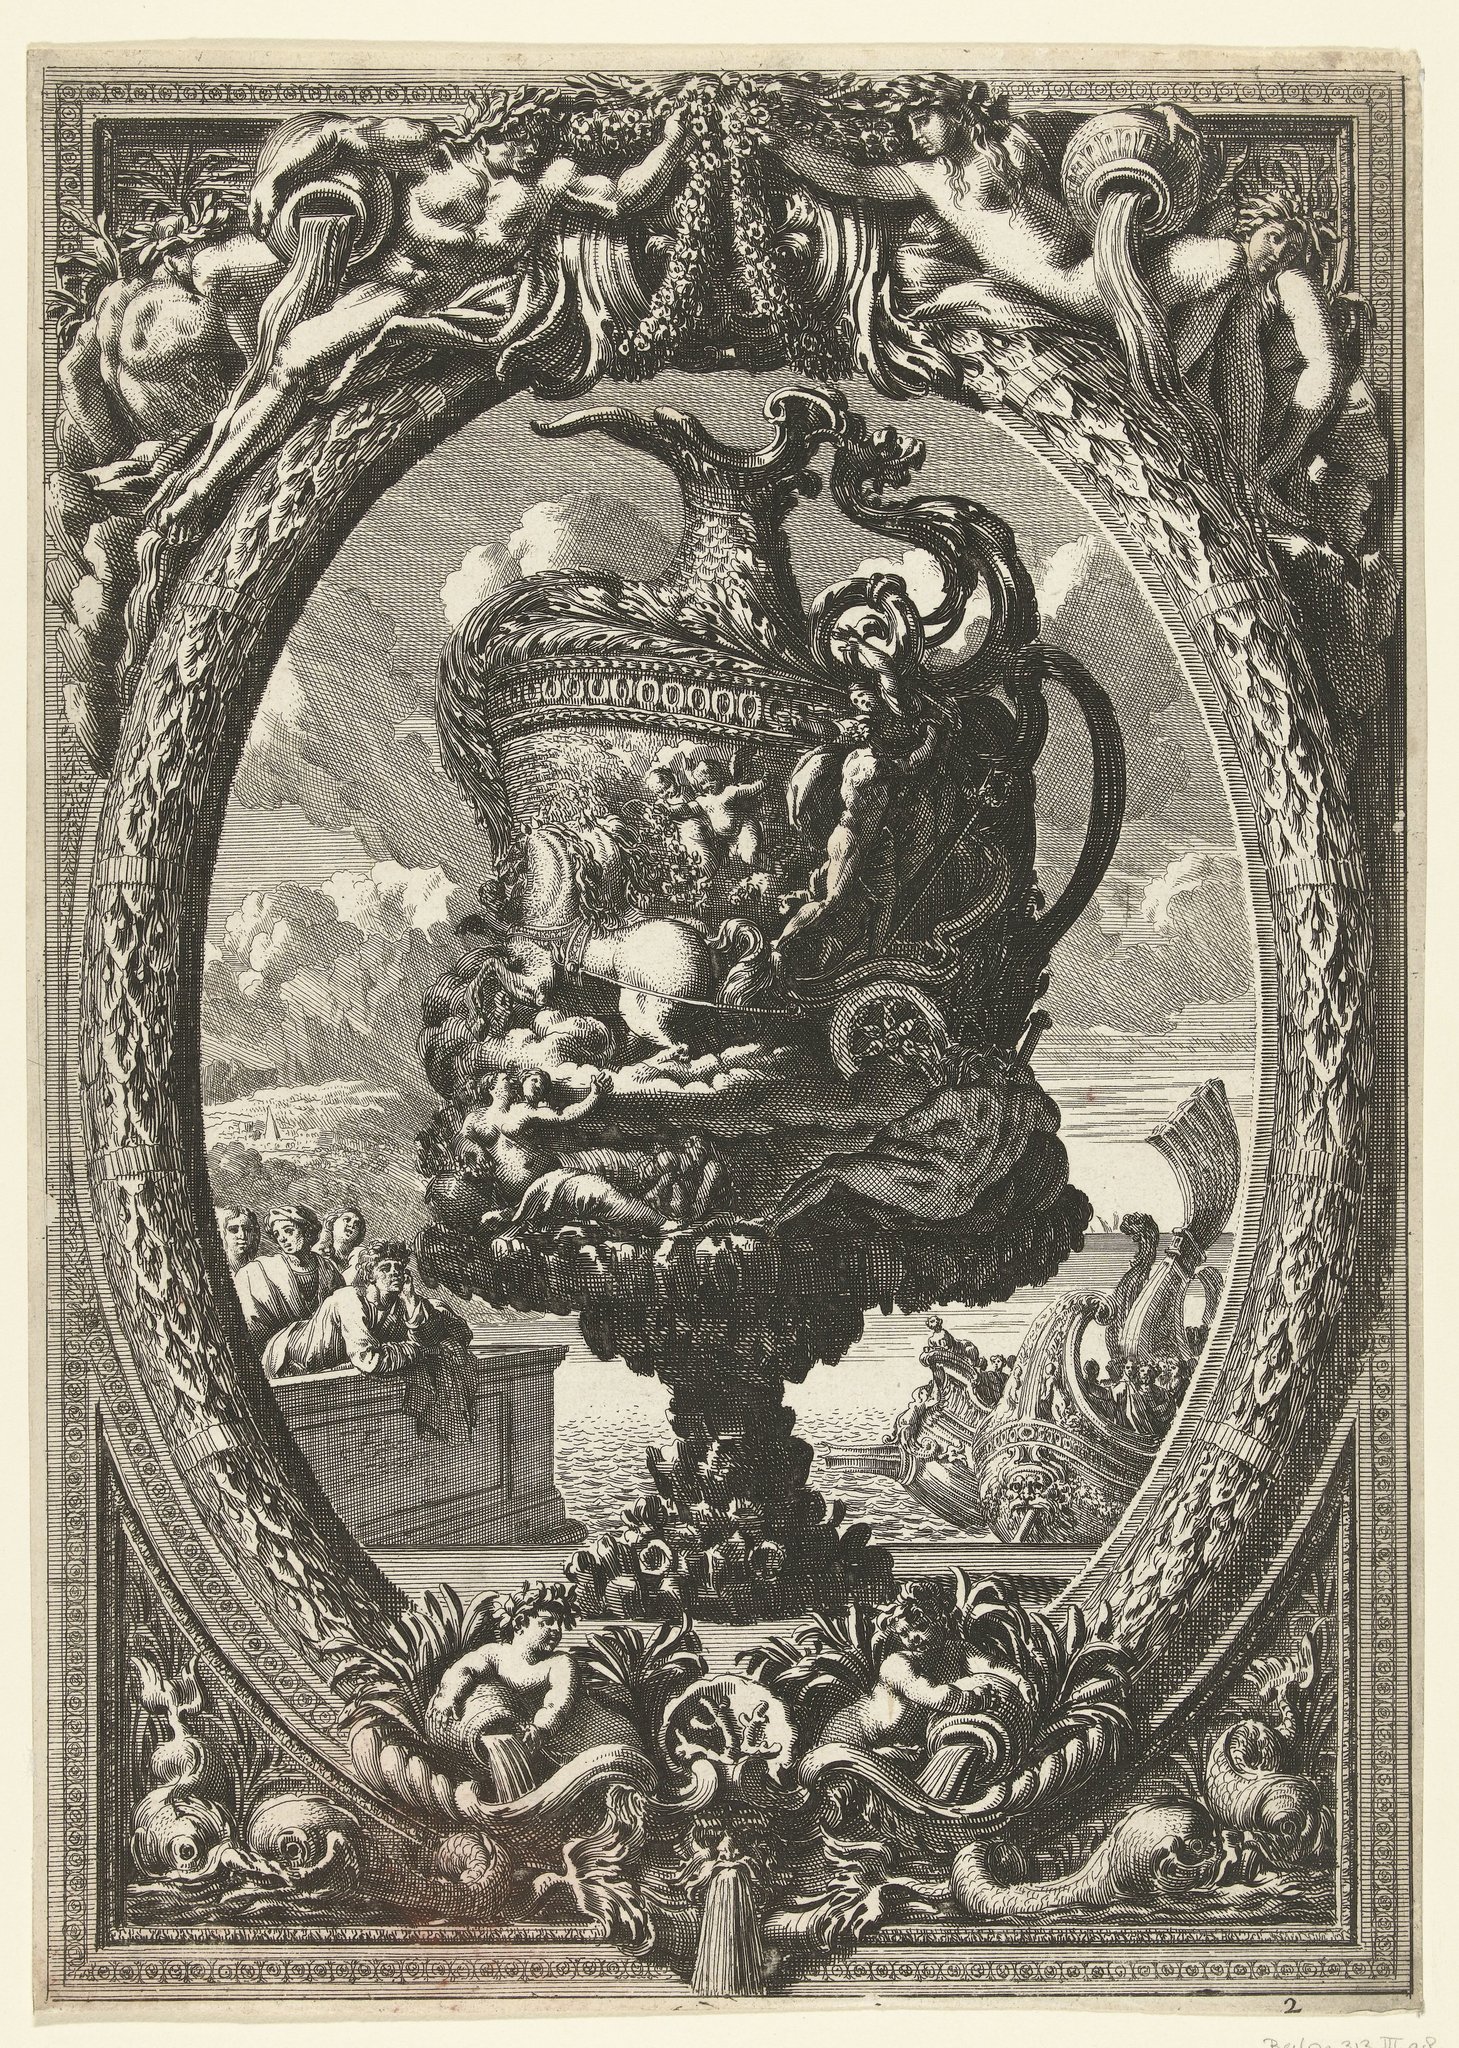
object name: print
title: Schenkkan met Neptunus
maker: jean lepautre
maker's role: draughtsman, print maker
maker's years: 1618-1682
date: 1650-1664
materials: paper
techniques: etching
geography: france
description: De vaas staat in een ovale lijst met kleine dolfijnen links- en rechtsonder.